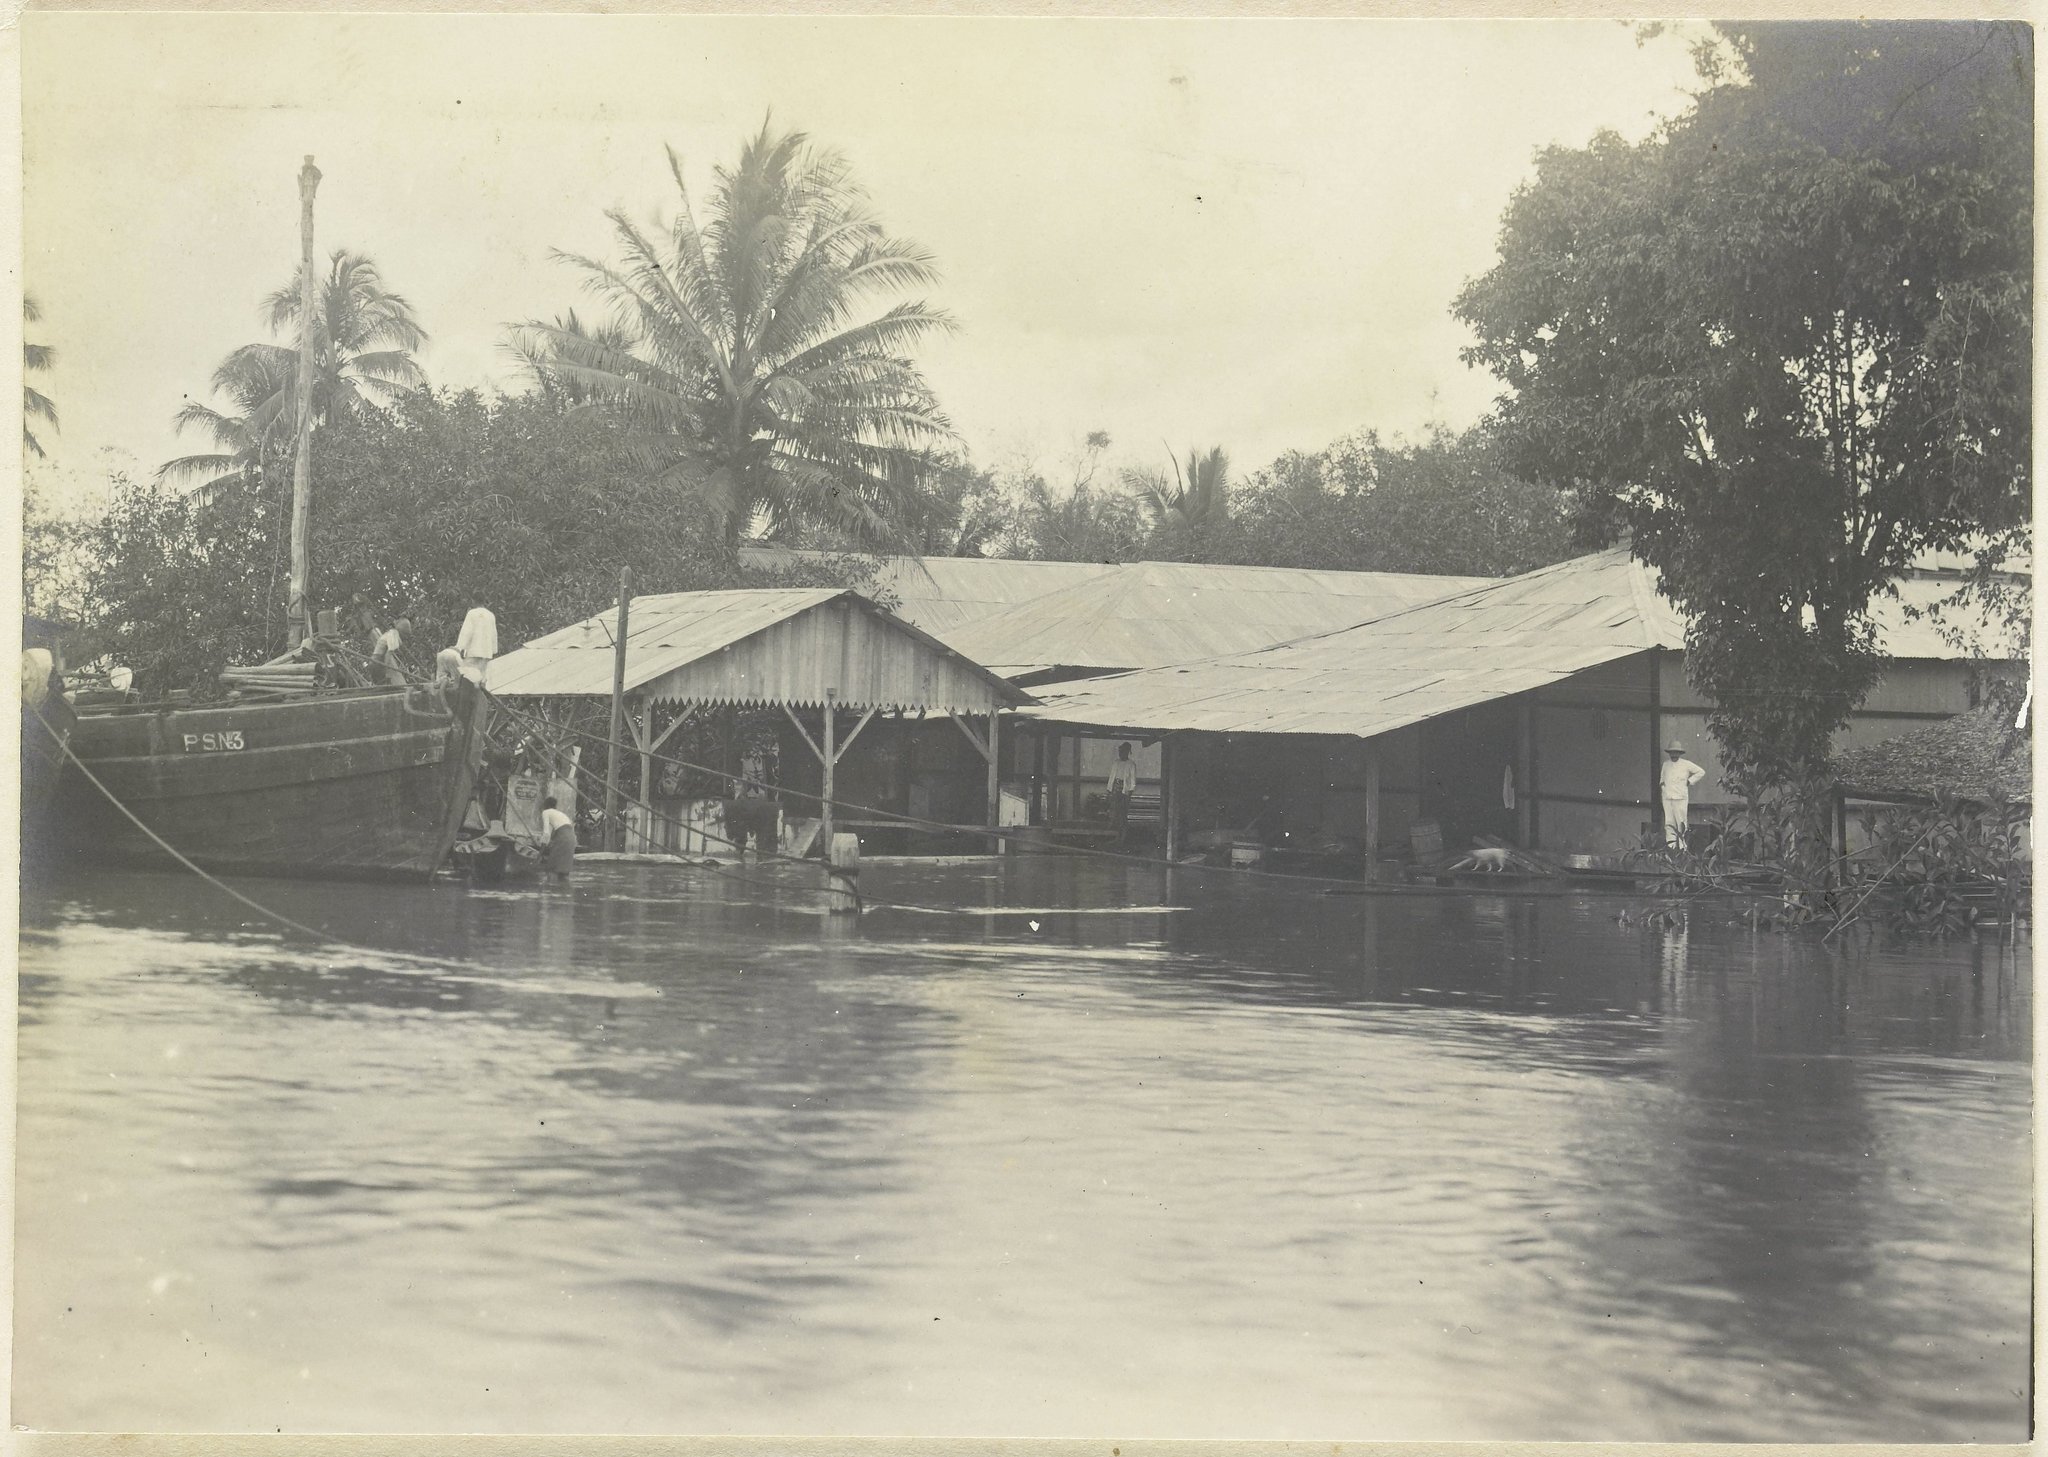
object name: photograph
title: Hoog water op Wampoerivier bij de Sandelbrug, Tandjong Poera, Langkat Sumatra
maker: Anonymous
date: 1900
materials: cardboard, paper, photographic support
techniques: gelatin silver print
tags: sumatra